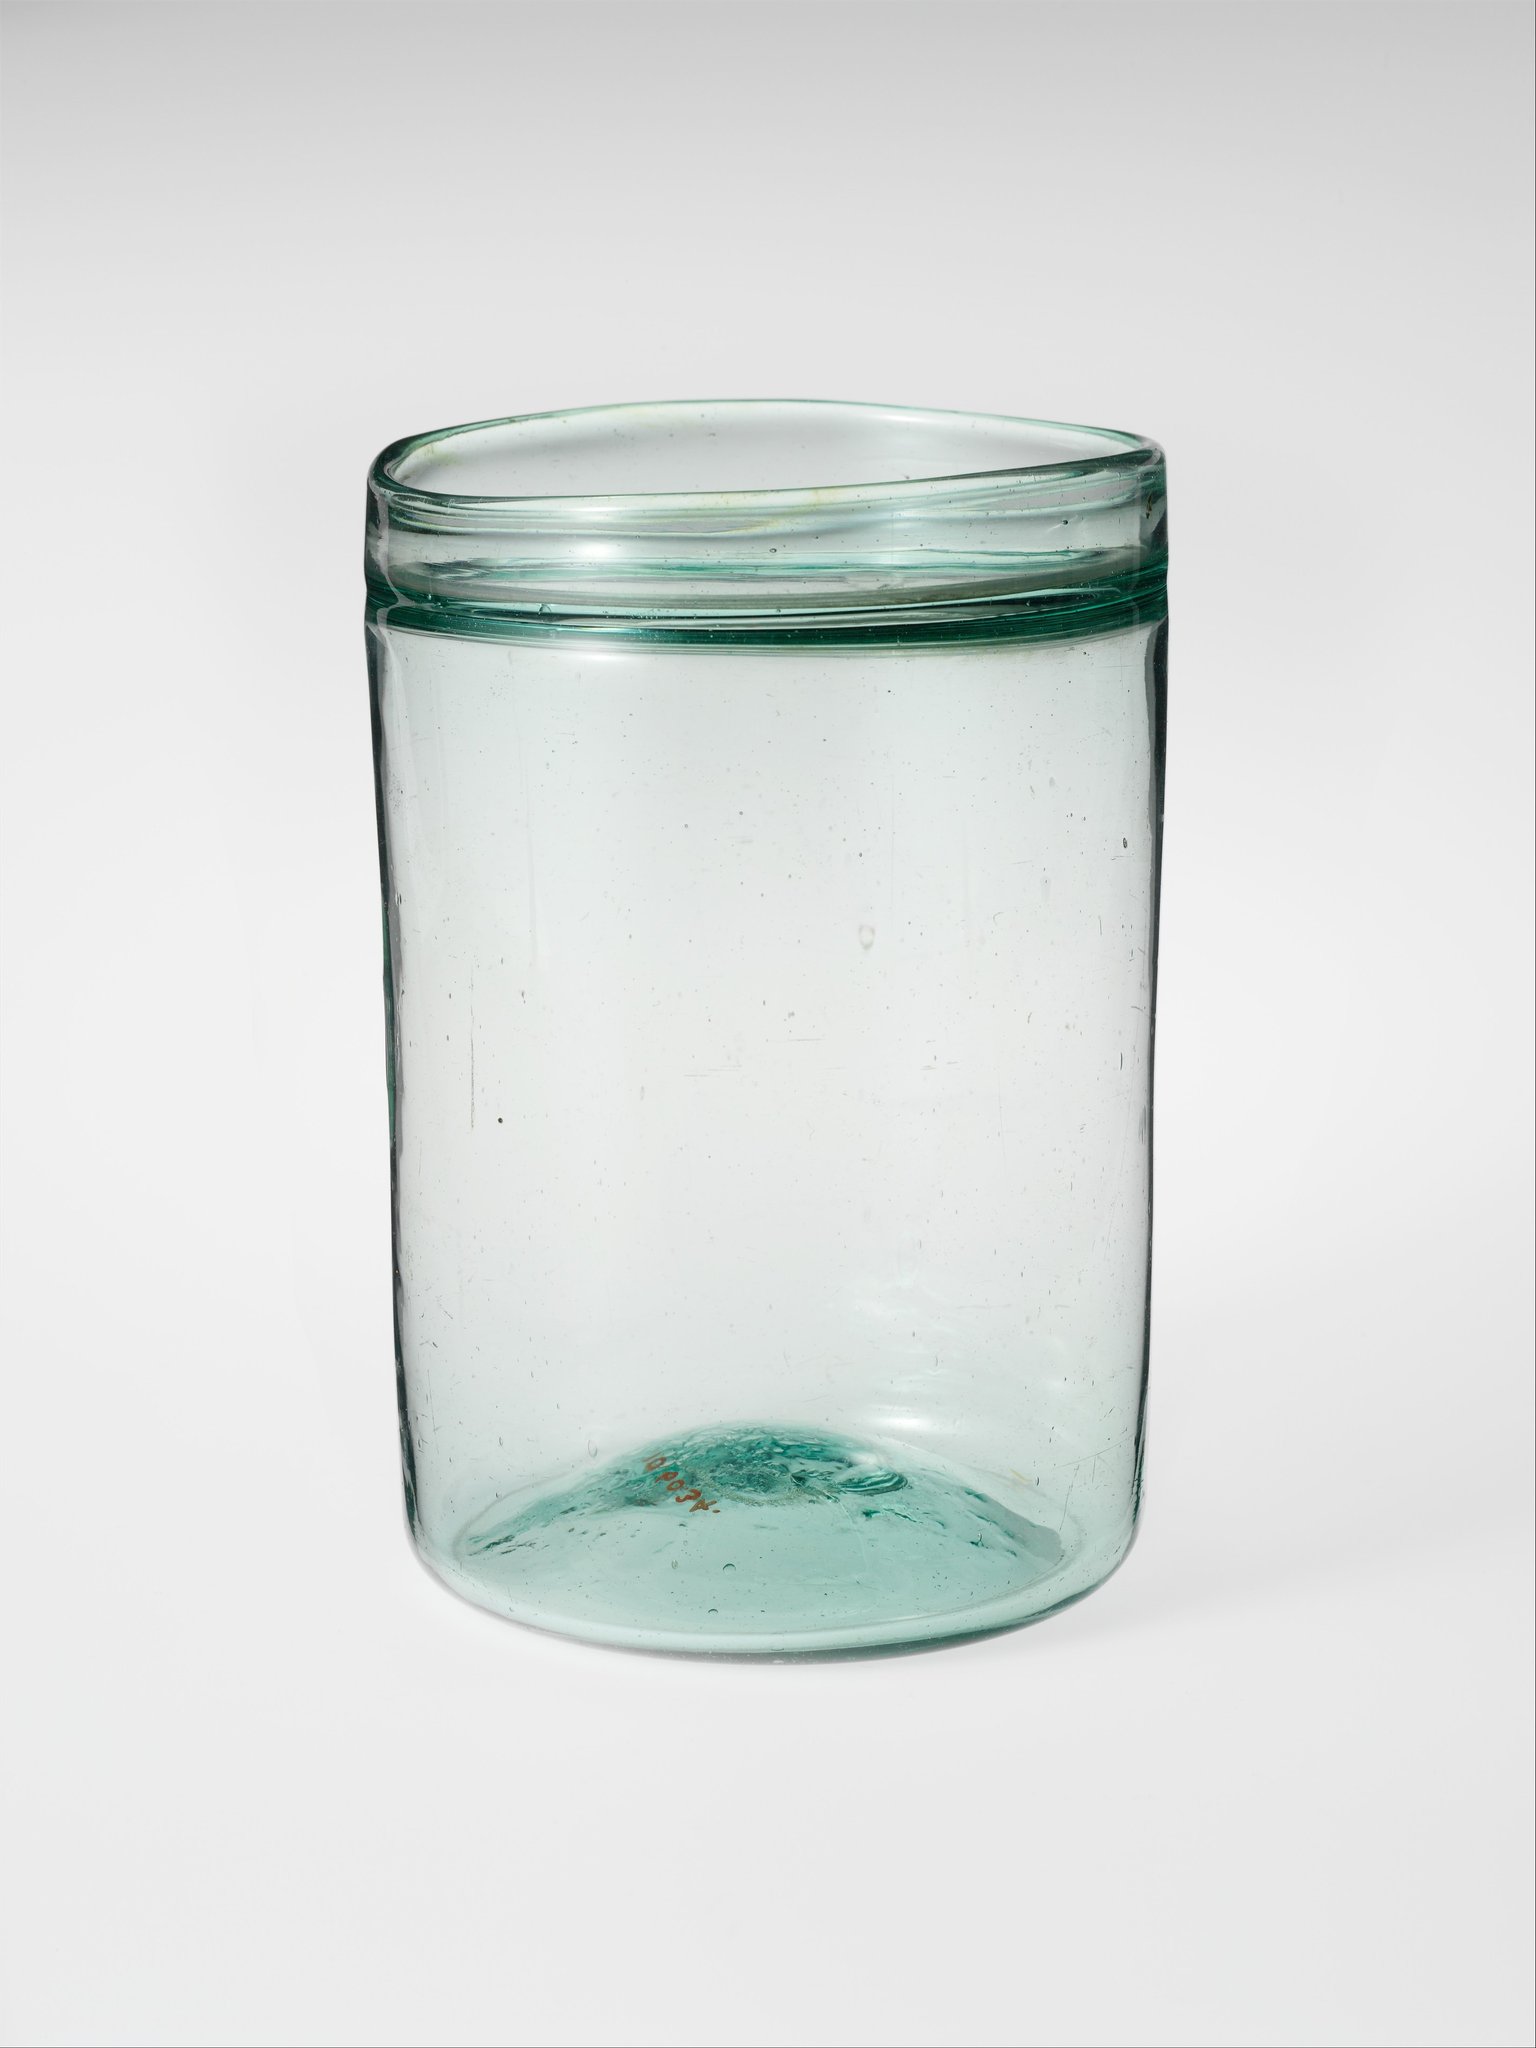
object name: jar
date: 1801-1900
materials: gemstone, glass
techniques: glassblowing